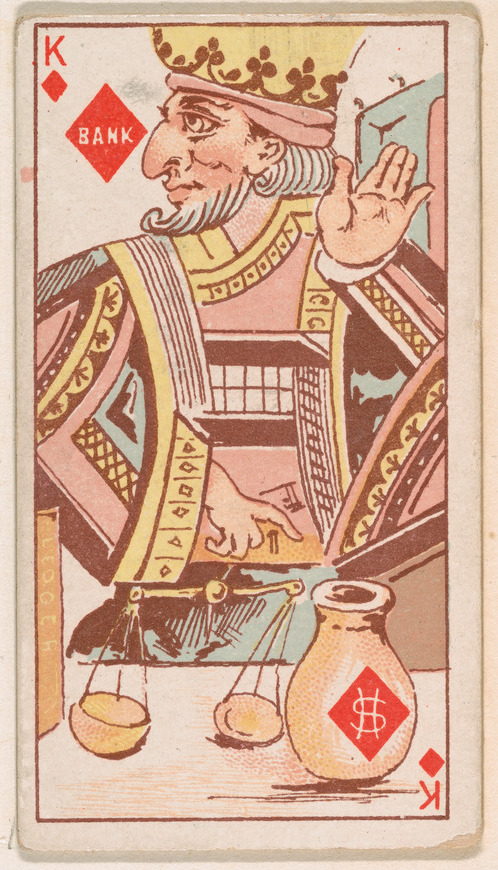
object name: print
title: King of Diamonds, from Harlequin Cards, 2nd Series (N220) issued by Kinney Bros.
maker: kinney brothers tobacco company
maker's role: publisher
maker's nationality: american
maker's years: 1869-2011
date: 1889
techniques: color lithograph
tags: kings,playing cards